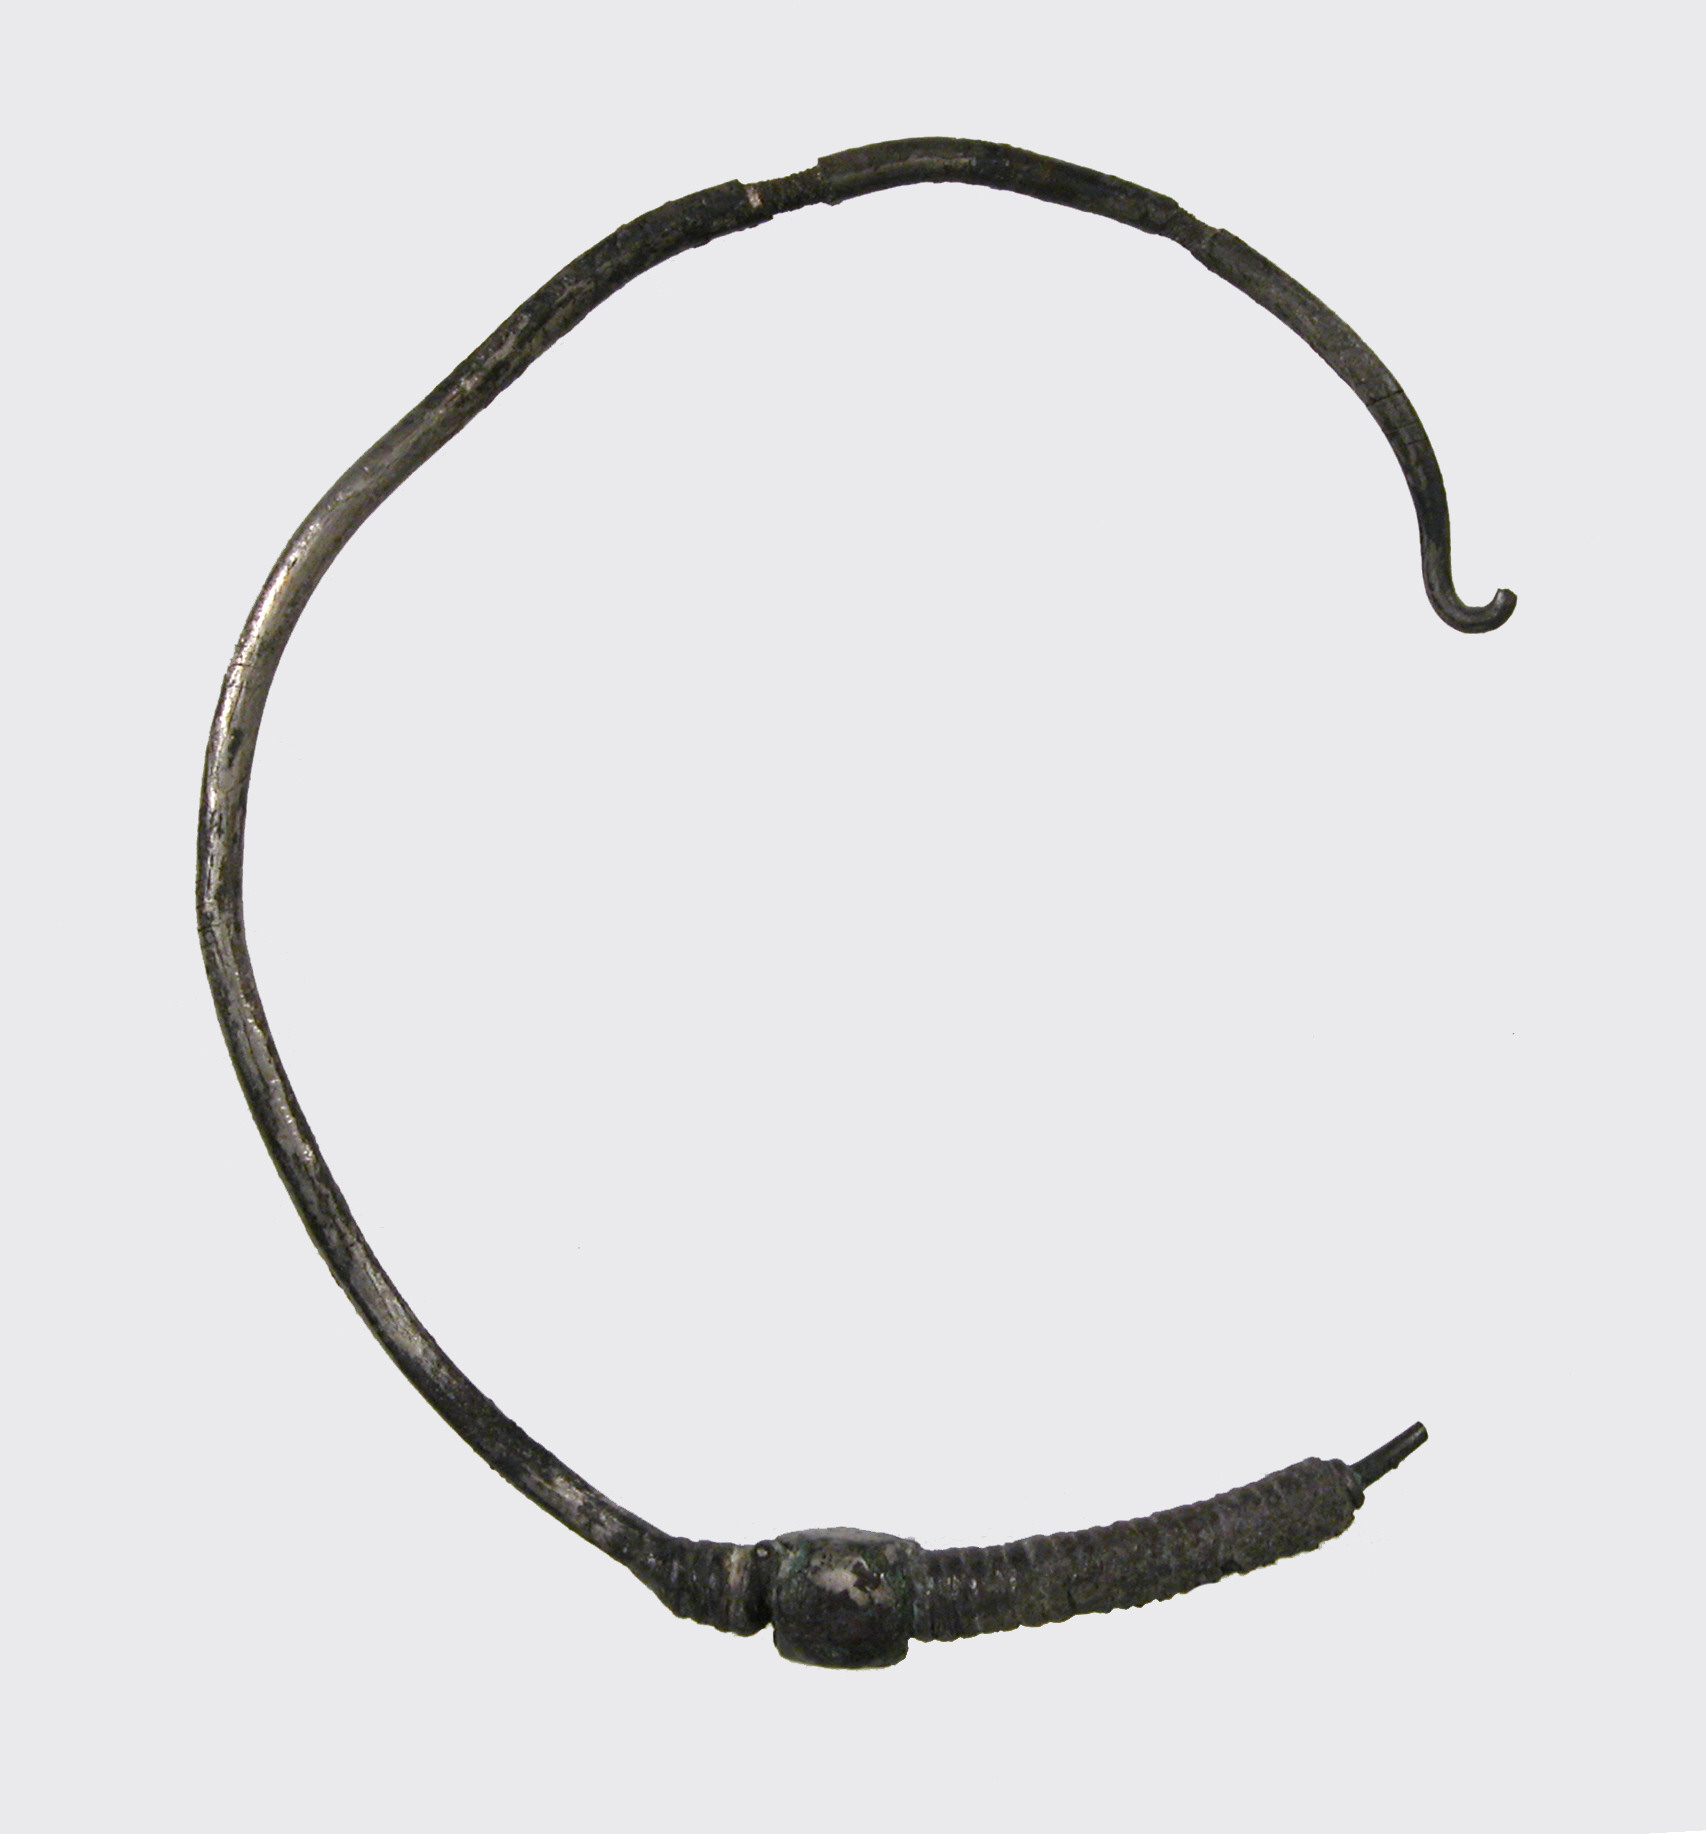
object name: earring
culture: frankish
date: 601-700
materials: silver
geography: germany